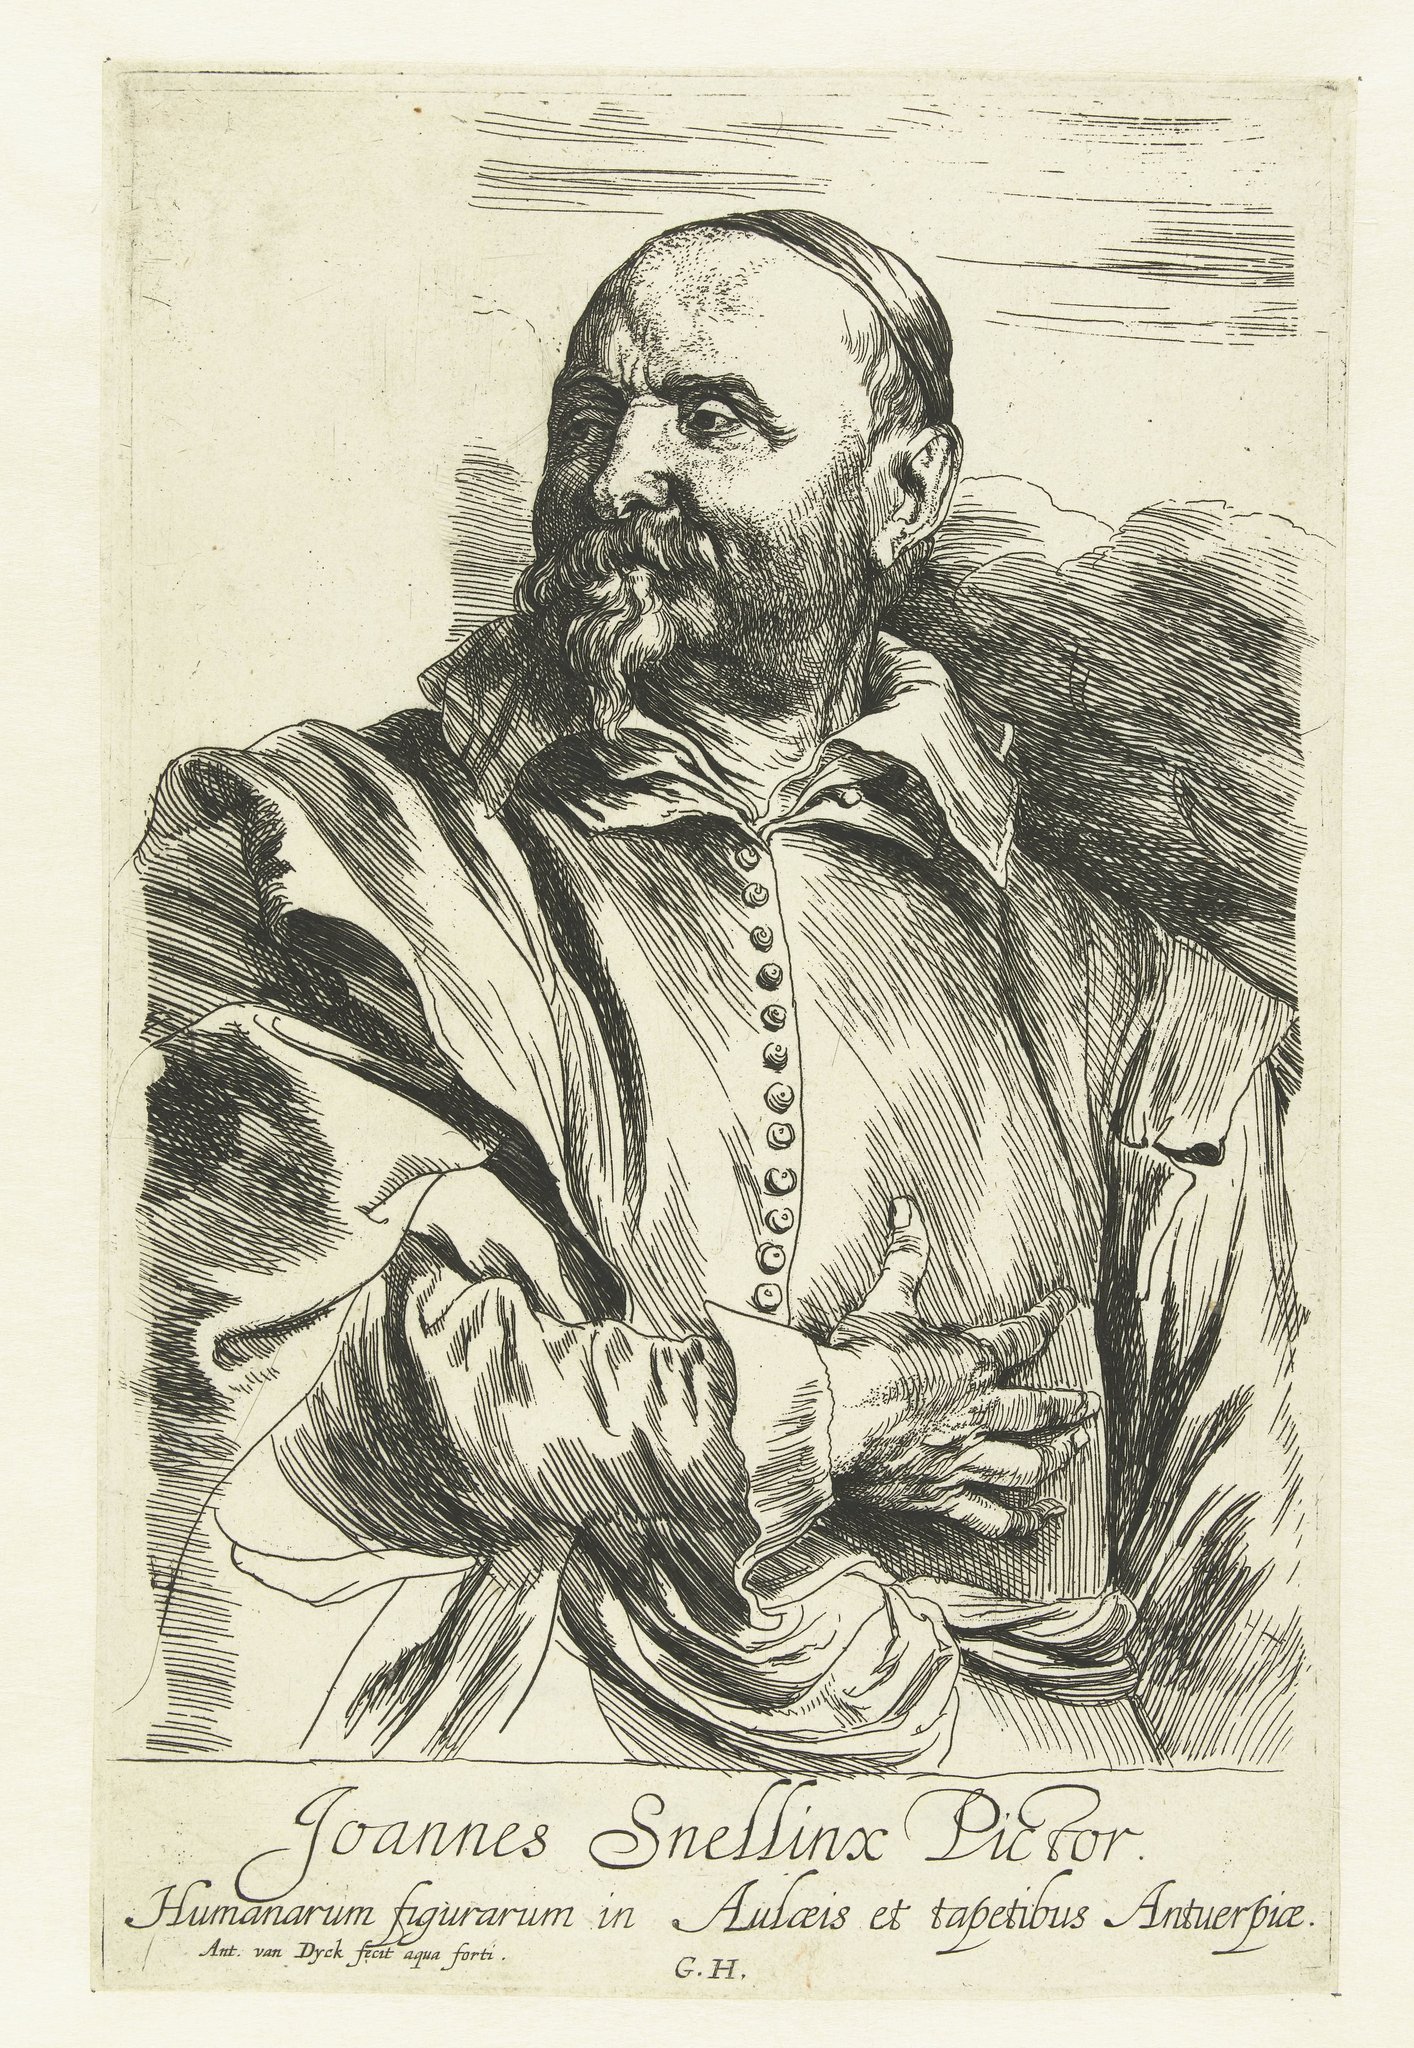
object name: print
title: Iconographie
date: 1630-1636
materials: paper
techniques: engraving, etching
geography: low countries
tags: mechelen, painter, jan snellinck (i), portrait, self-portrait of painter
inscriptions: collector's mark: Lugt 2166, collector's mark: Lugt 2228a, collector's mark: Lugt 2760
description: Portret van kunstenaar Jan Snellinck met onderschrift Joannes Snellinx Pictor Humanarum figurarum in Aulaeis et tapetibus Antuerpiae